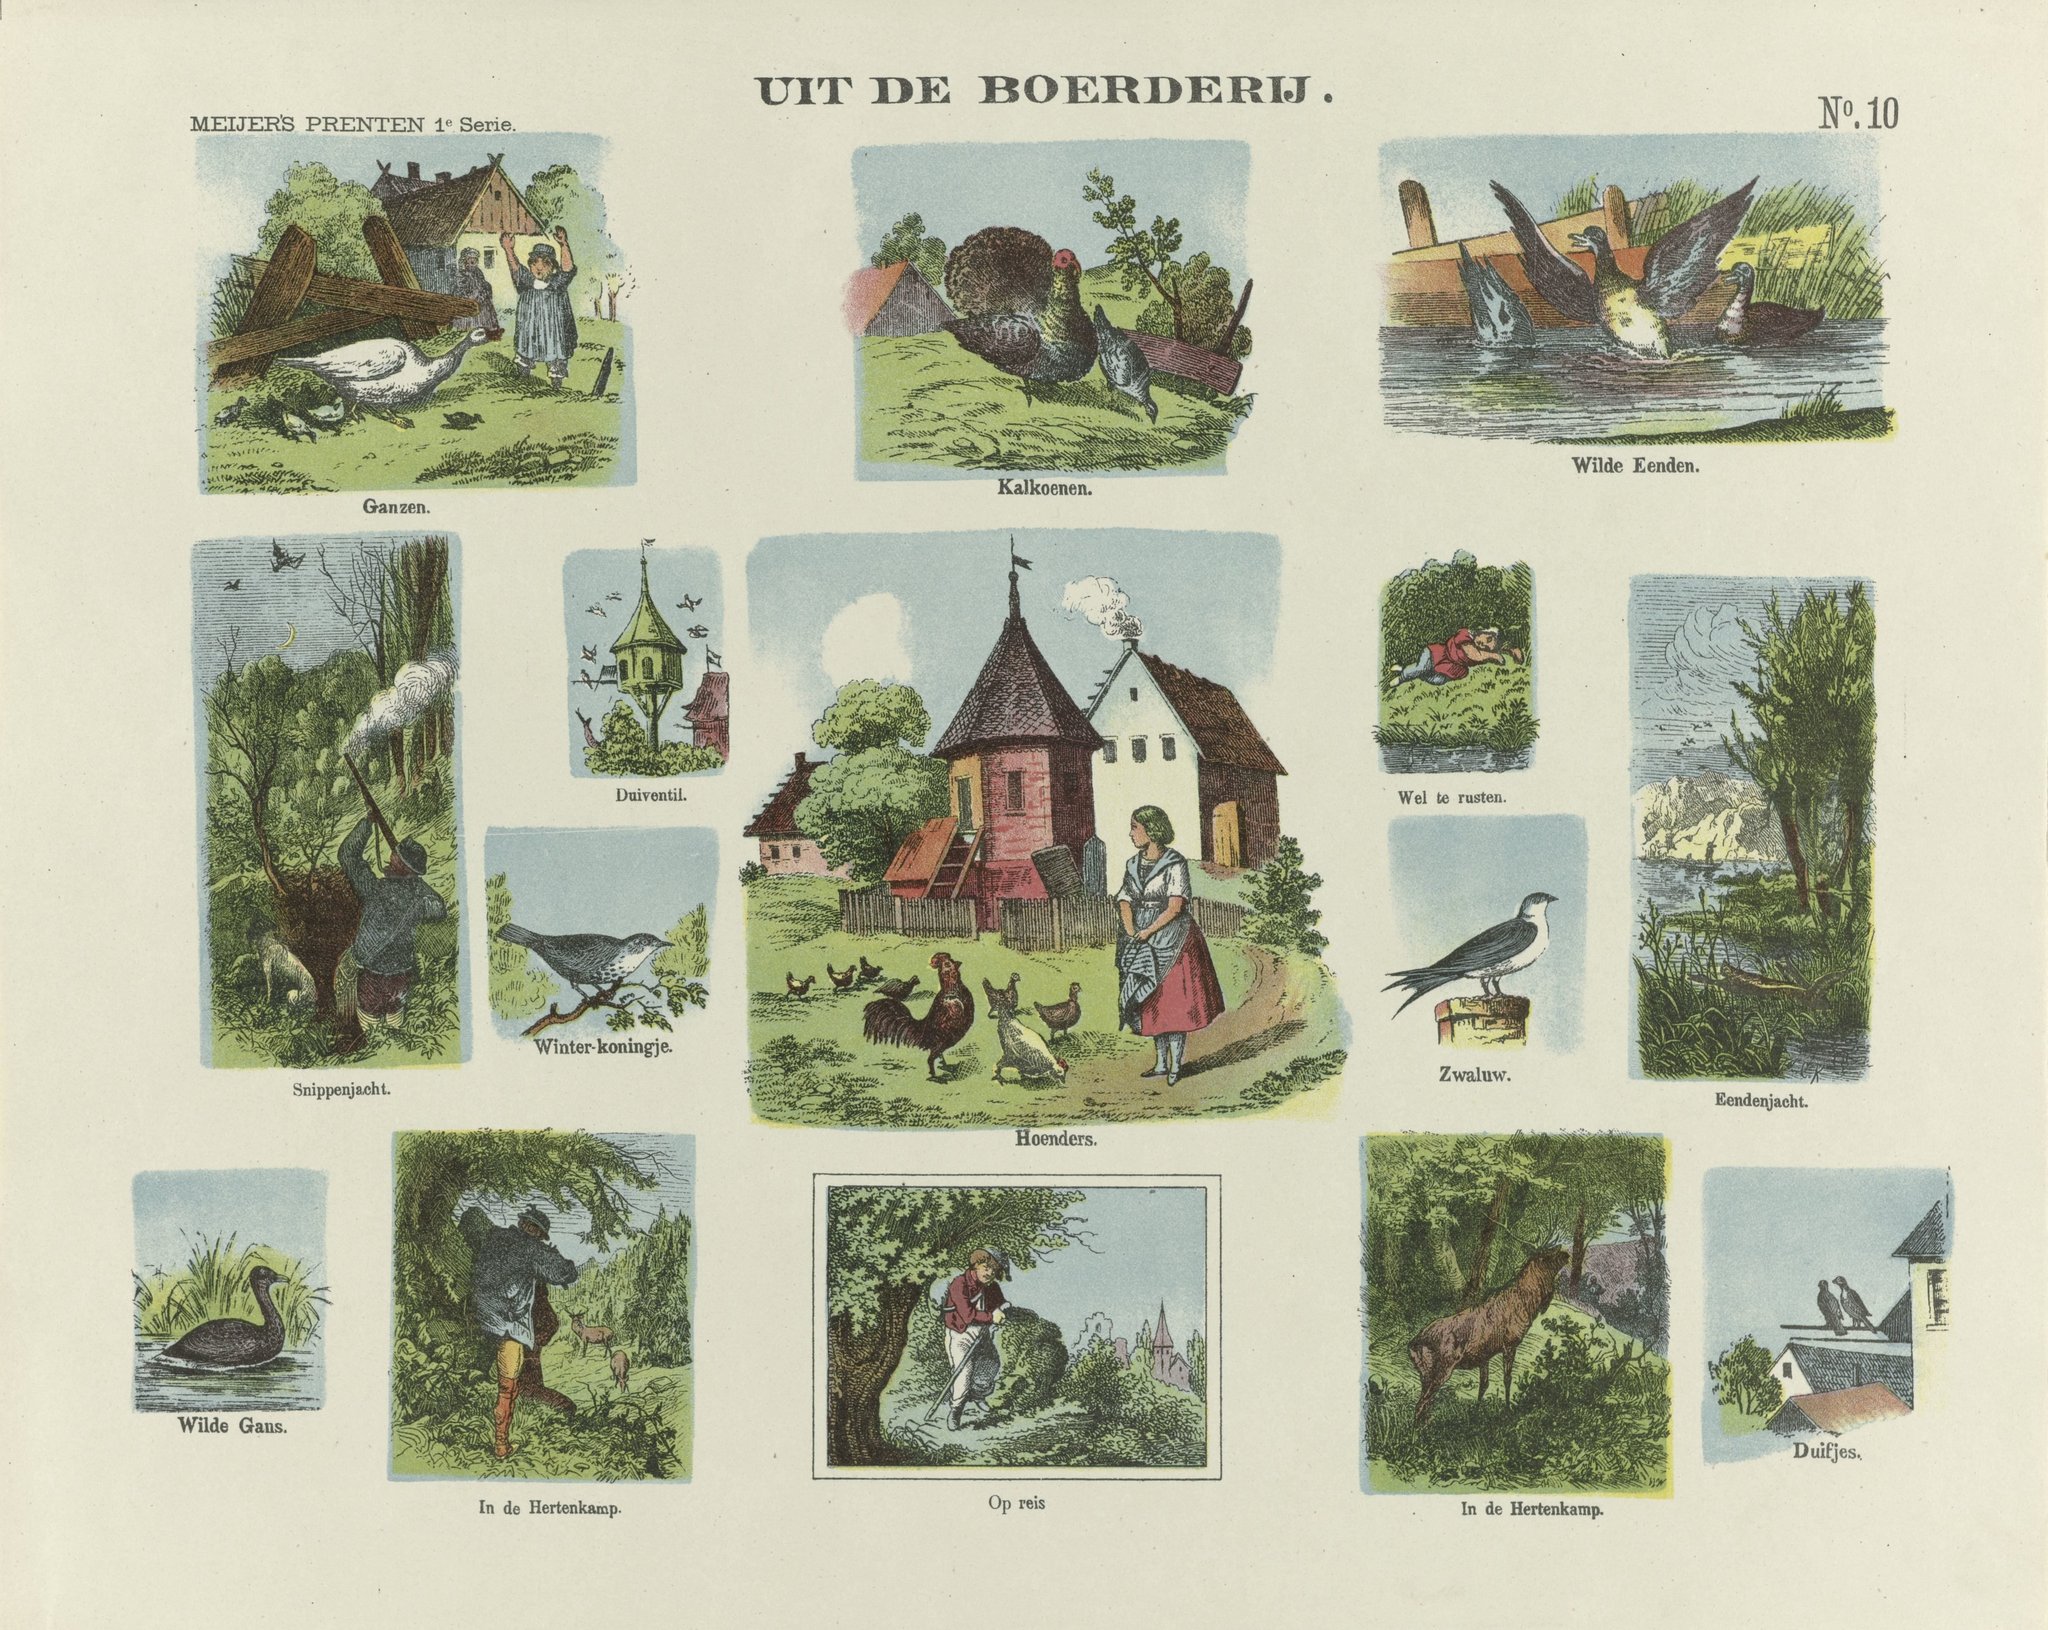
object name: print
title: Uit de boerderij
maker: Anonymous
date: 1873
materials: paper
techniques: lithograph, letterpress printing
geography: amsterdam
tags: animals, water-birds: goose, hunter, farmers - aa - female farmer, farmer's wife, fowl (cock, hen, chicken, etc.)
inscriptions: collector's mark: Lugt 2760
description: Blad met 15 voorstellingen van boerderijdieren en boerderijtaferelen. Onder elke afbeelding een onderschrift. Genummerd rechtsboven: No. 10.